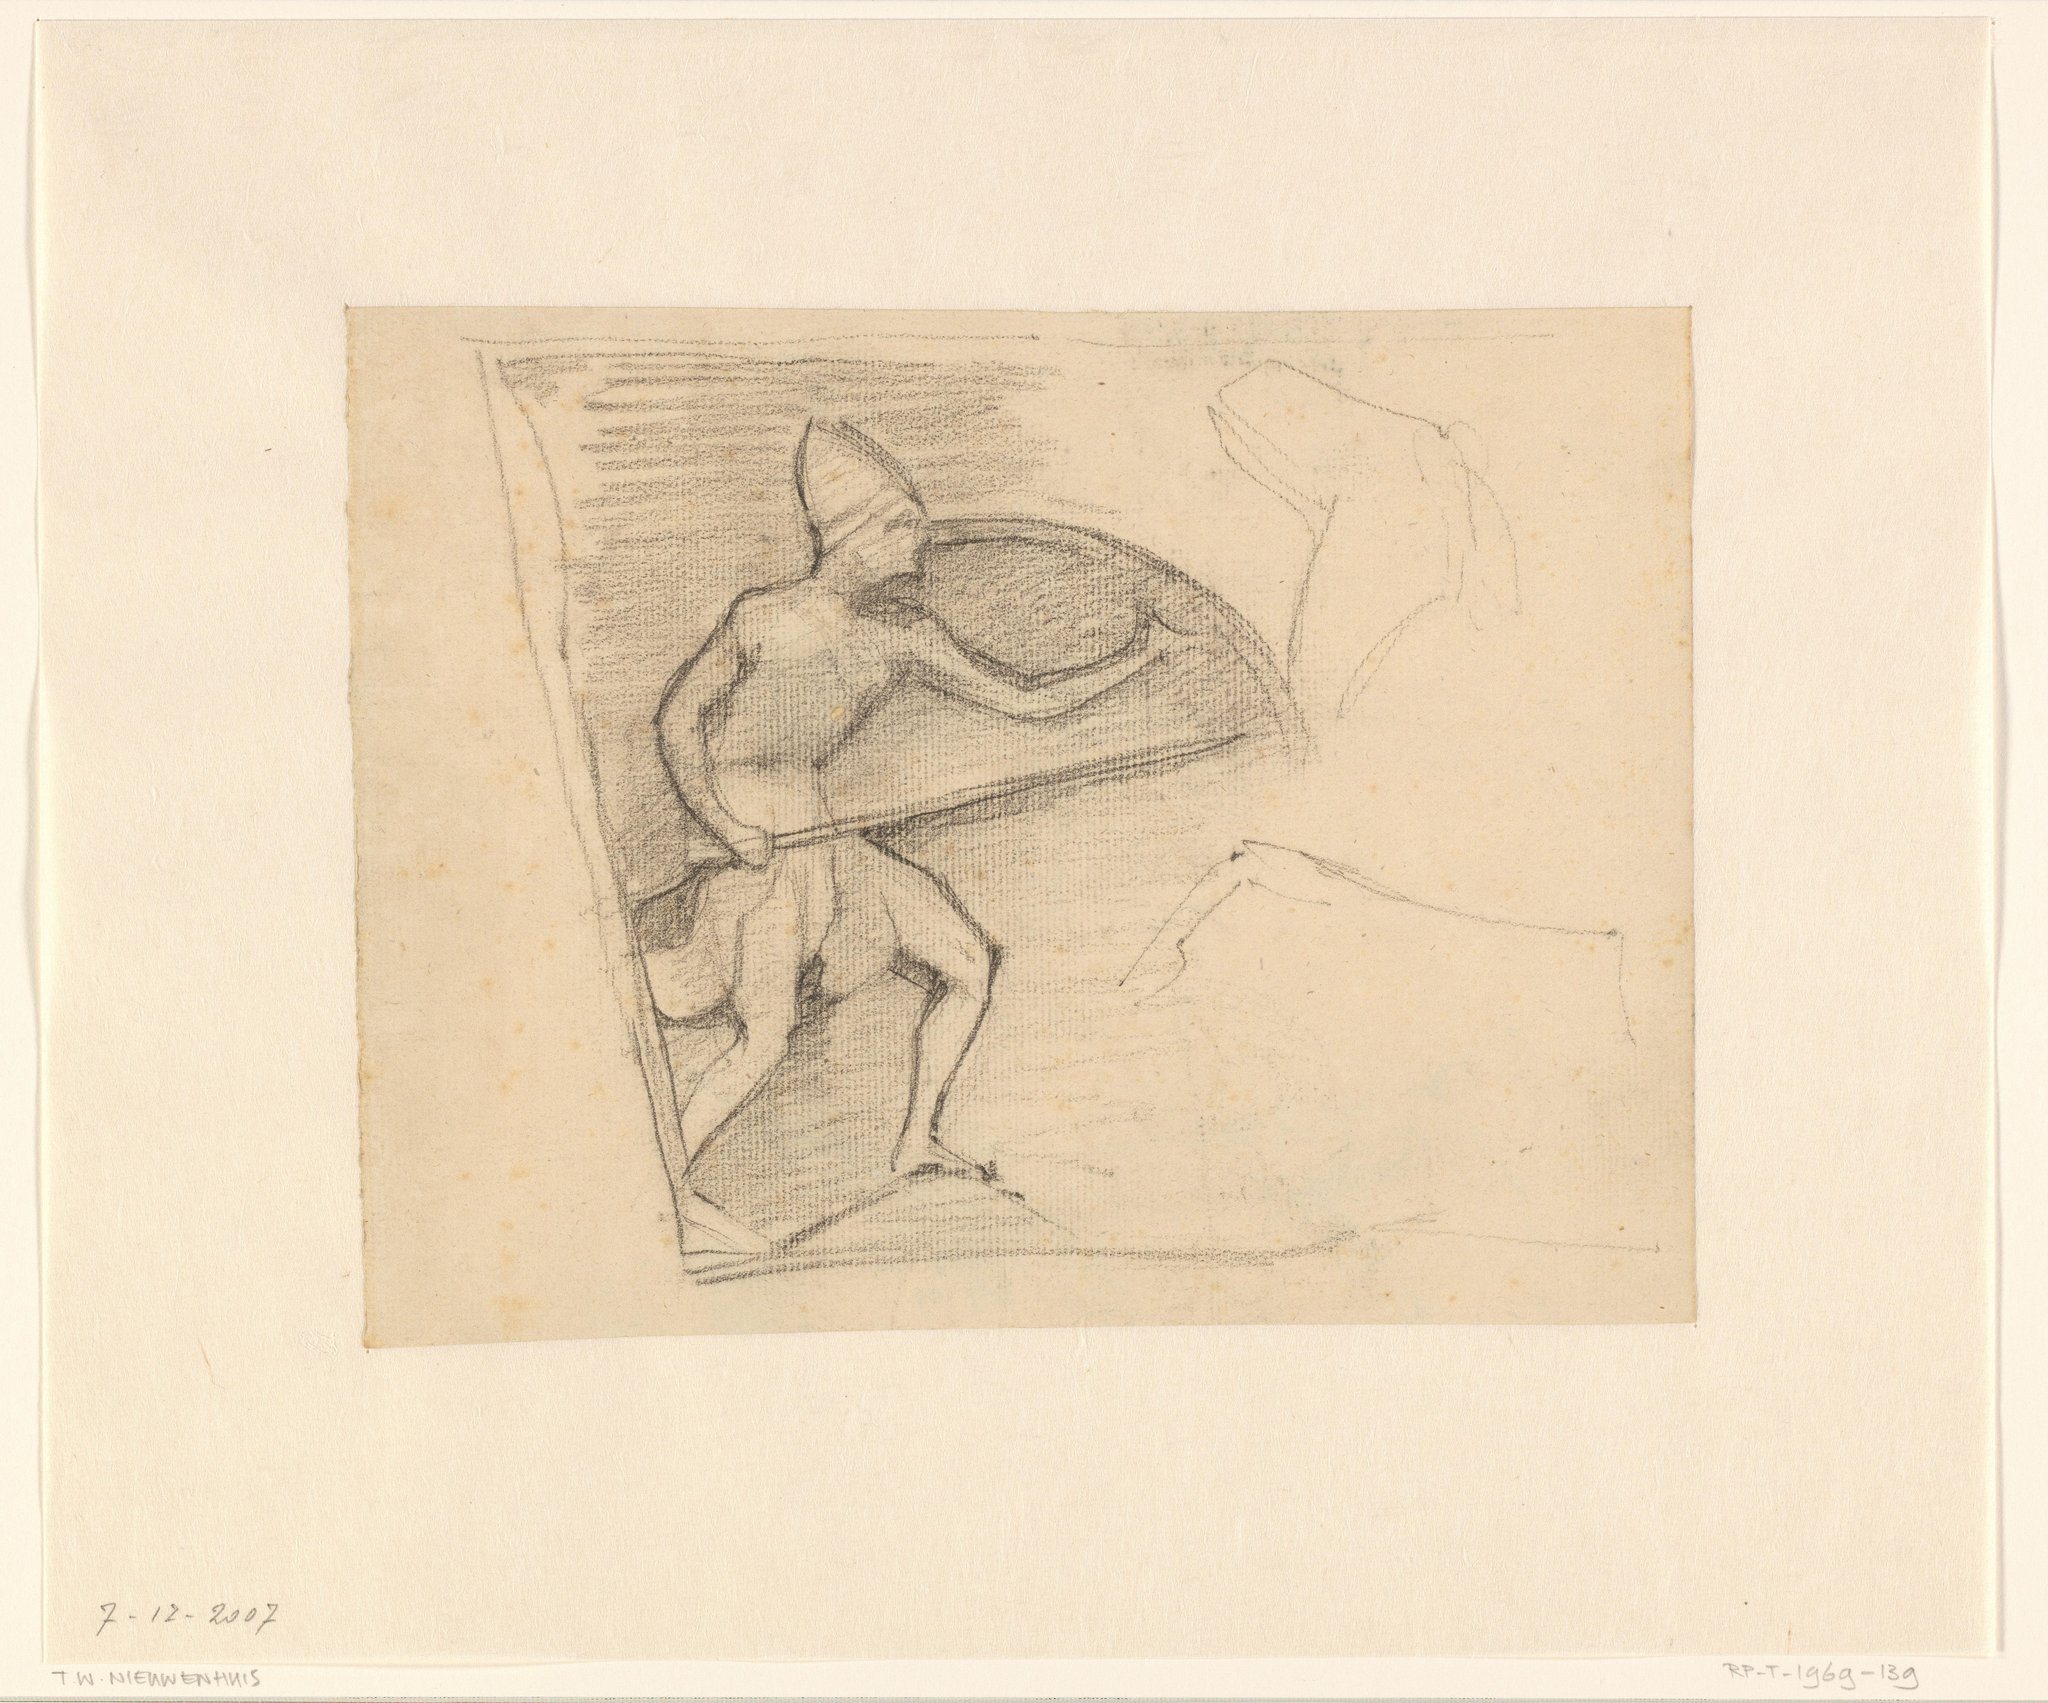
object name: drawing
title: Krijgsman met schild en zwaard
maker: theo nieuwenhuis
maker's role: designer, draughtsman, print maker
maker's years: 1866-1951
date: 1876-1951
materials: chalk, paper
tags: private soldier, piece of sculpture, reproduction of a piece of sculpture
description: Krijgsman met schild en zwaard, naar een reliëf.